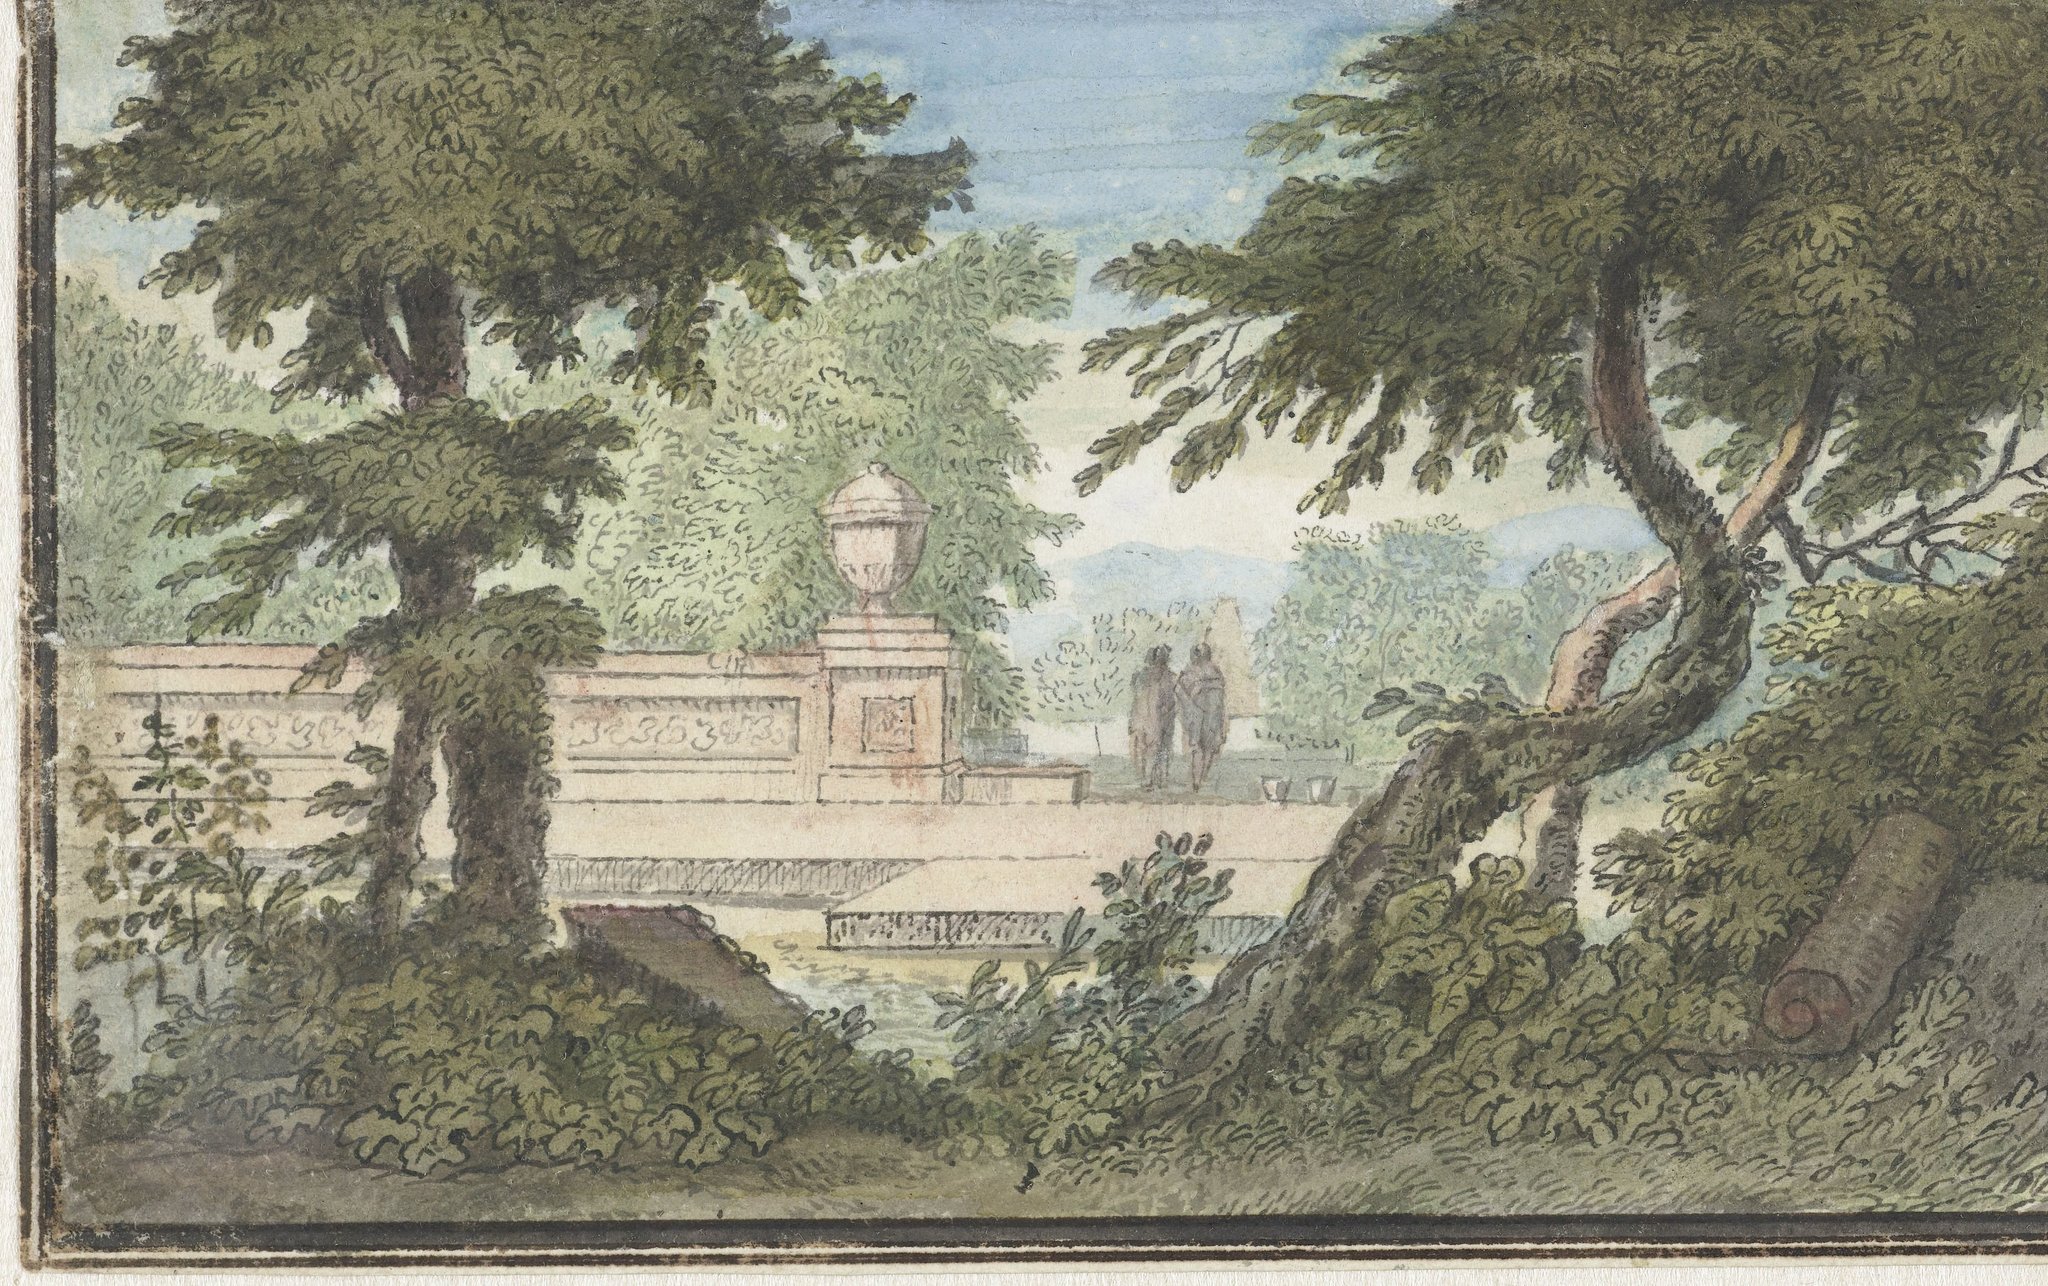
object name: drawing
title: Arcadisch landschap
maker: jacob van liender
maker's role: draughtsman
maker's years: 1696-1759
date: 1706-1759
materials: chalk, ink, paper, watercolor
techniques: brush, pen